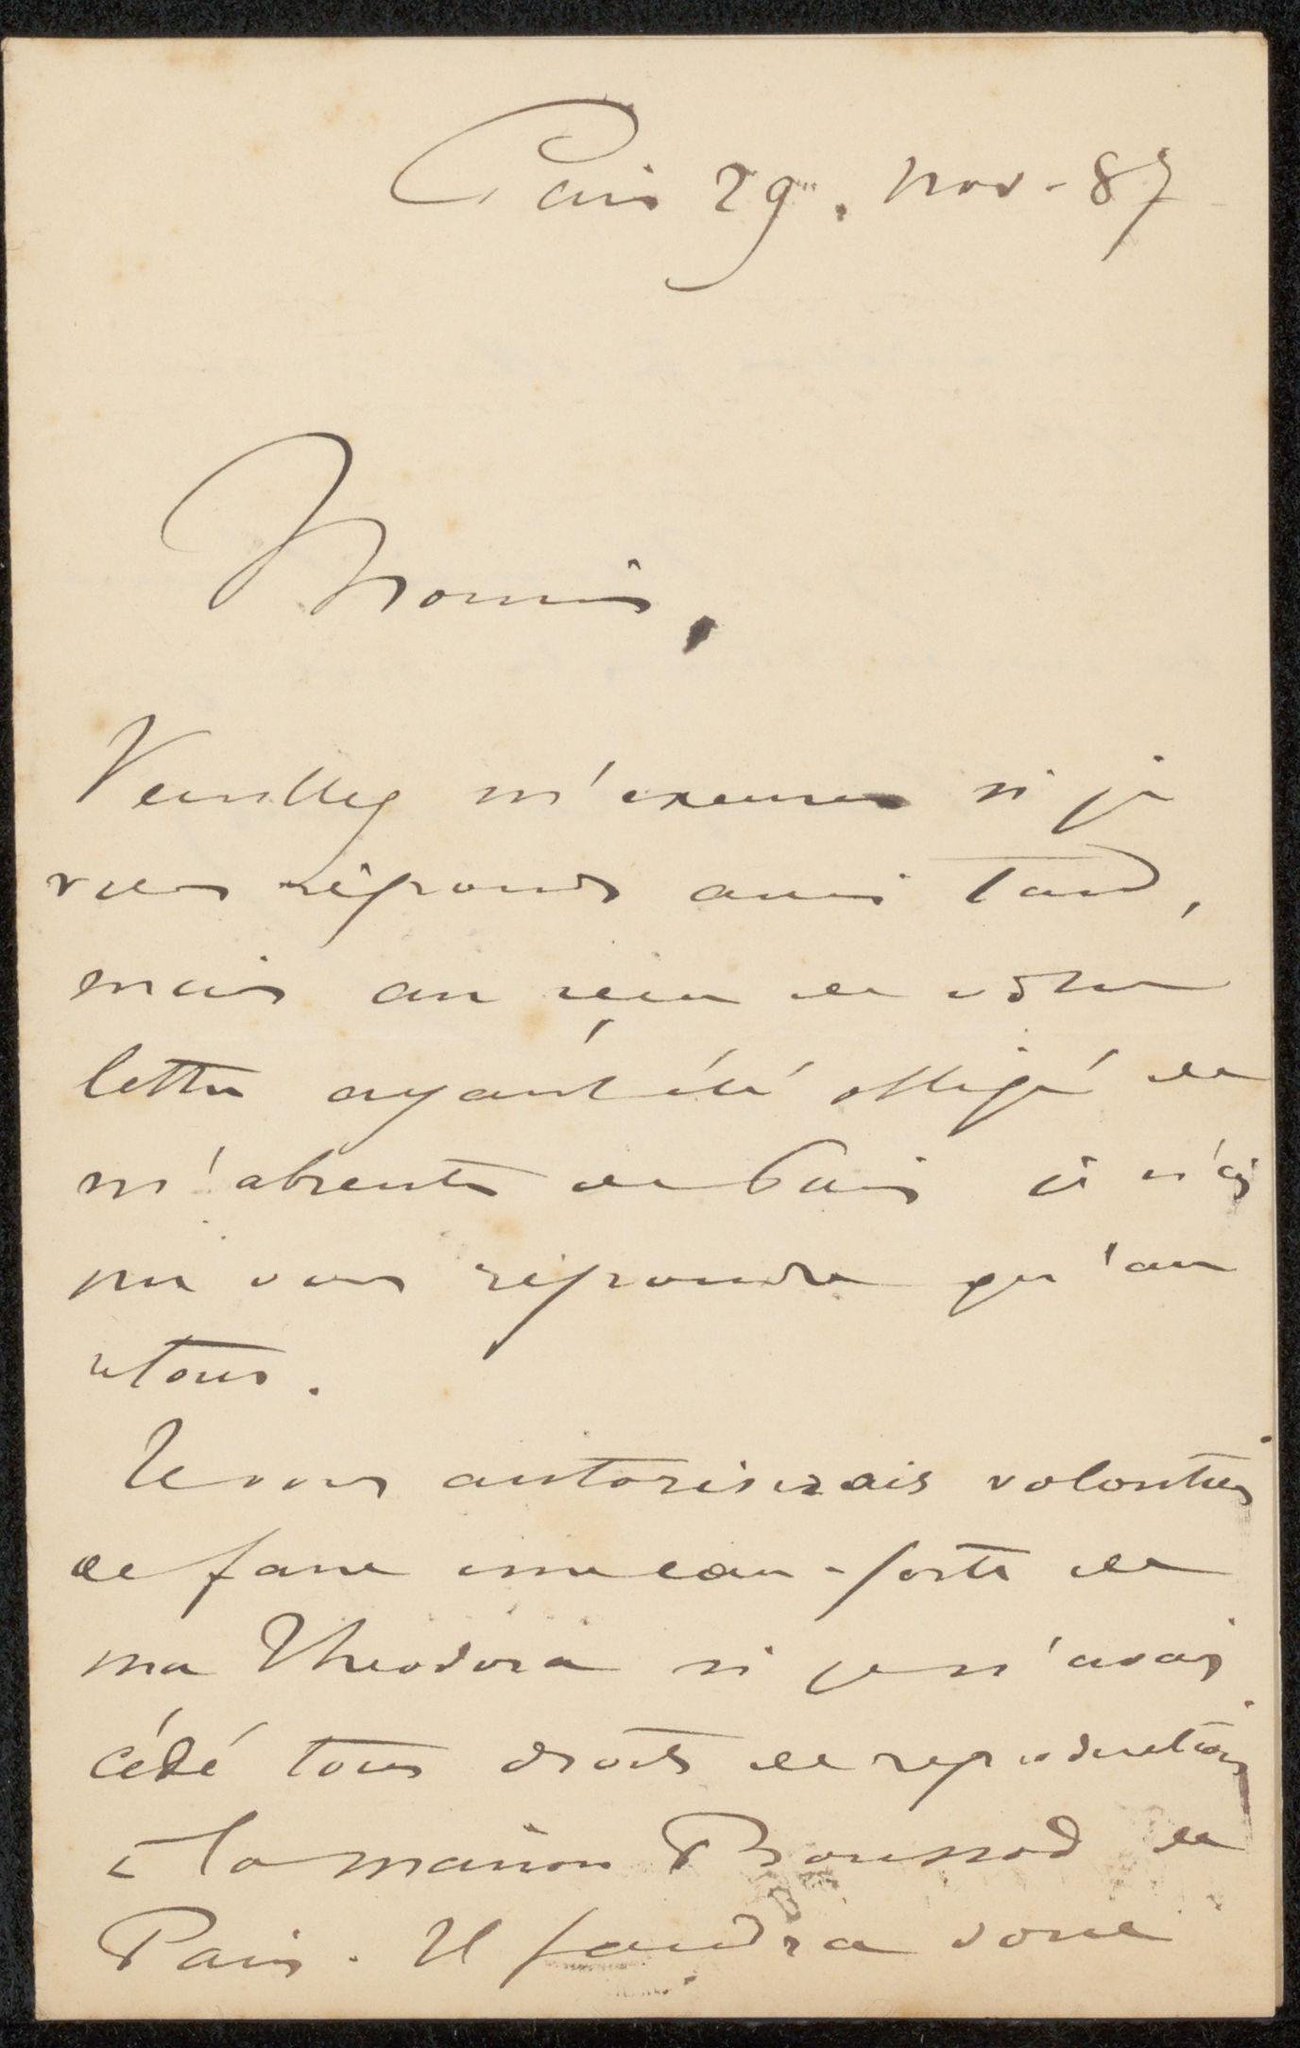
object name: letter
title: Brief aan Philip Zilcken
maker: benjamin constant (1845-1902)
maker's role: print maker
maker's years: 1845-1902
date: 1887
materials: ink, paper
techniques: pen, writing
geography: paris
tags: the hague, painter, draughtsman, philip zilcken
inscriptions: collector's mark: ‘RPK’, watermark